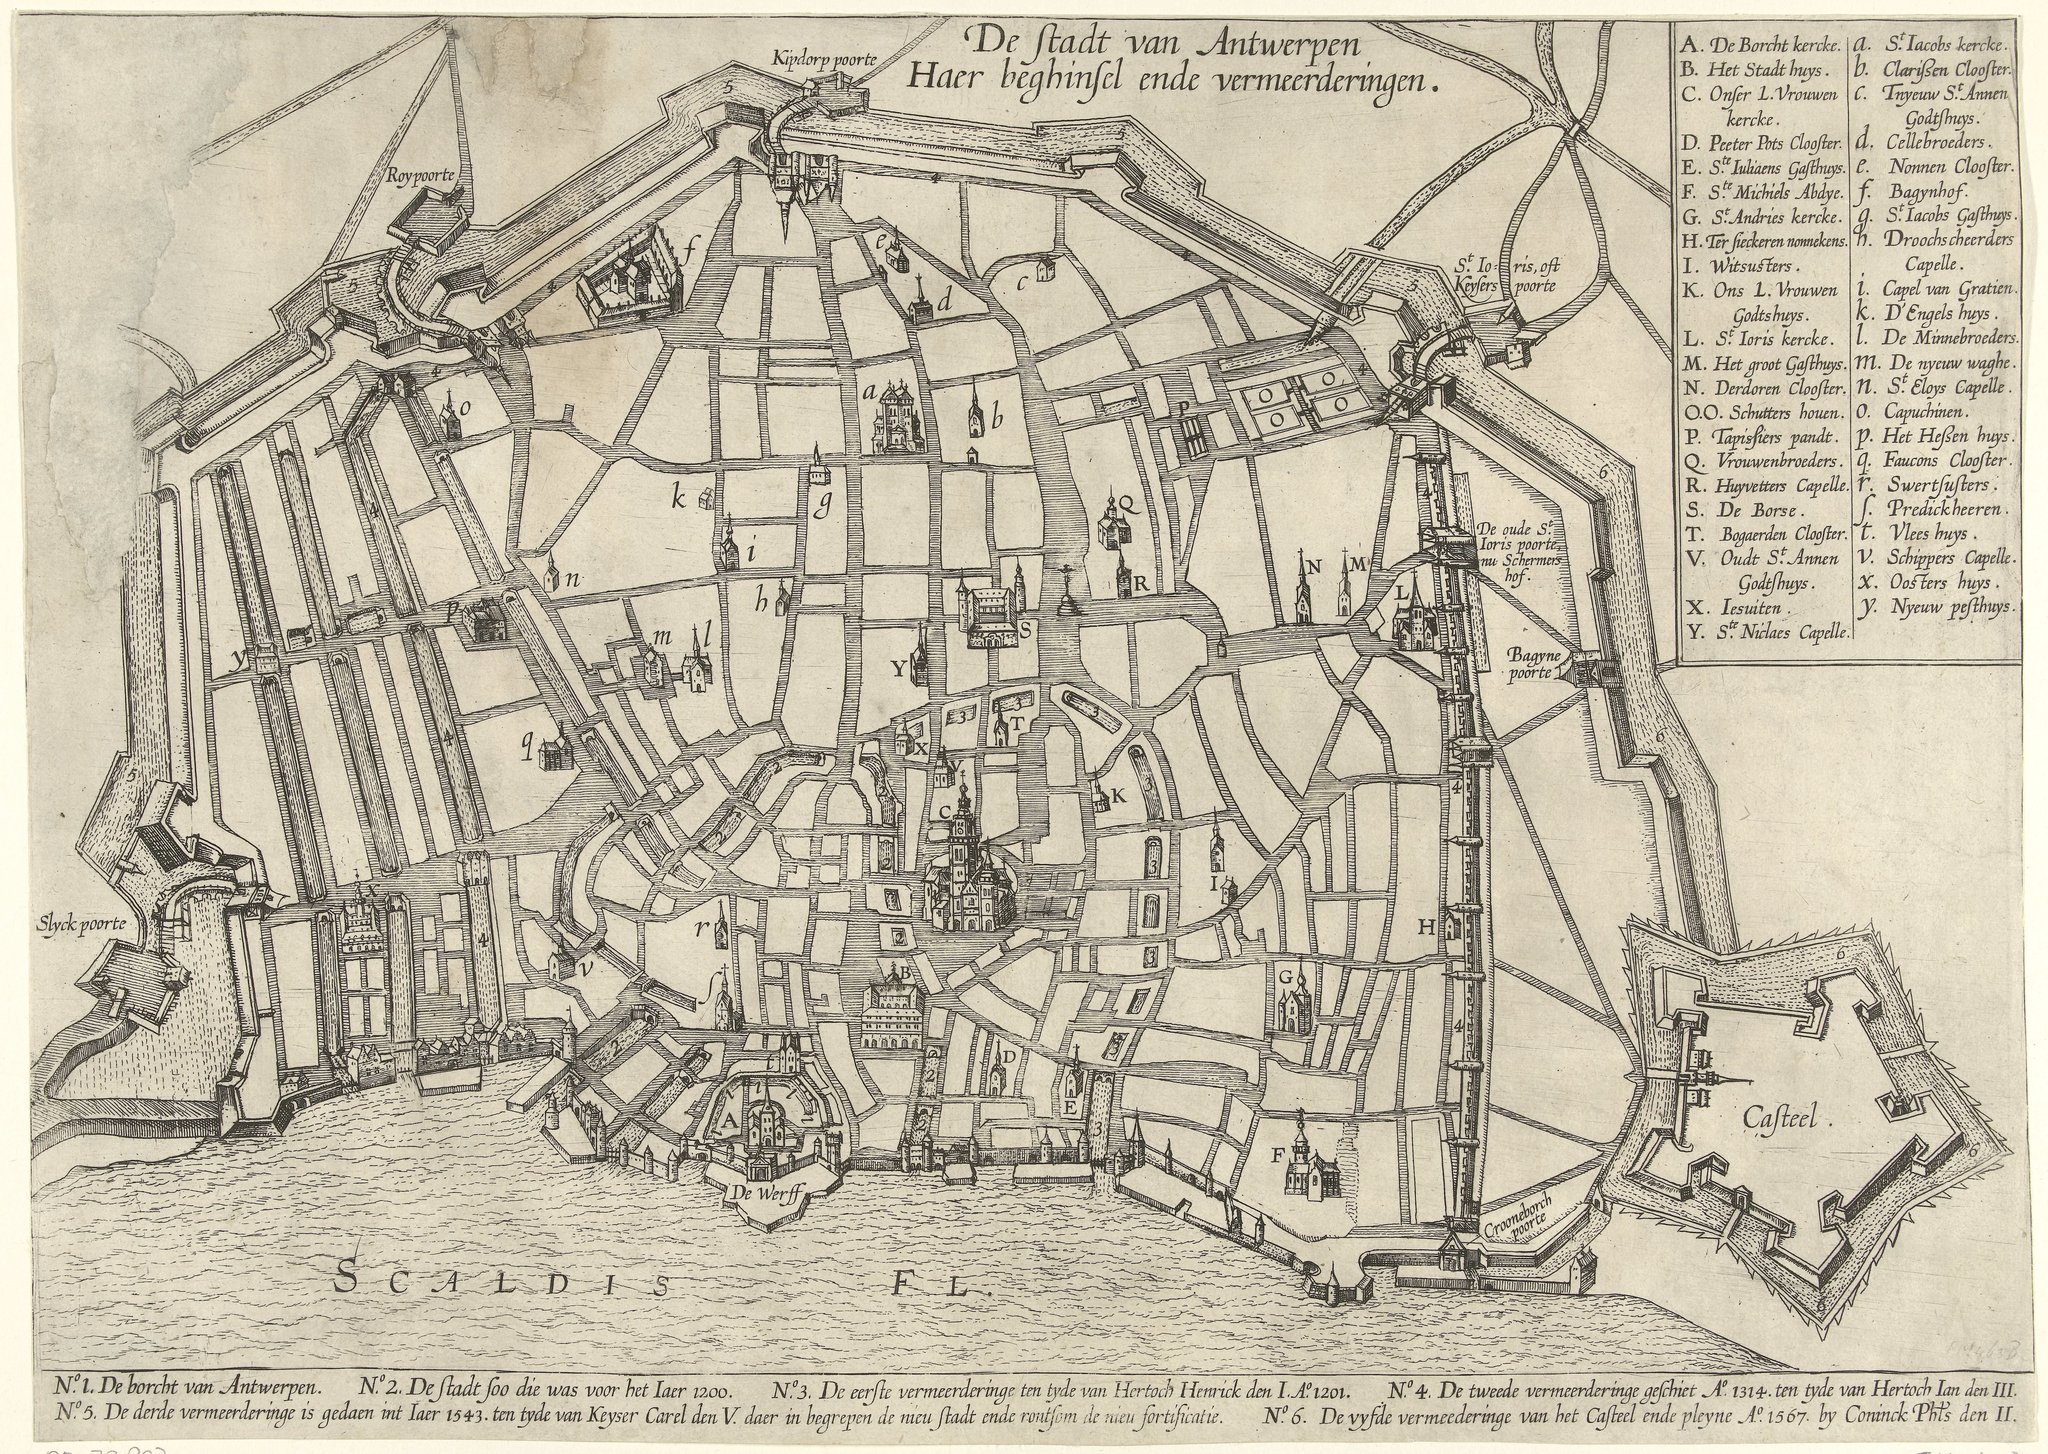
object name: map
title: De stadt van Antwerpen Haer beghinsel ende vermeerderingen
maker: Anonymous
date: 1575-1699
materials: paper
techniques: etching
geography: low countries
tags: maps of cities, antwerp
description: Plattegrond van Antwerpen met de historische ontwikkelingen en uitbreidingen over de jaren 1201-1567. Onderaan de Schelde, rechts het Kasteel. Met onderschrift van 2 regels in het Nederlands met de uitbreidingen 1-6. Rechtsboven een cartouche met de legenda A-Y en a-y. Hierbij gevoegd is een kolom tekst afkomstig uit een boek, in het Latijn.